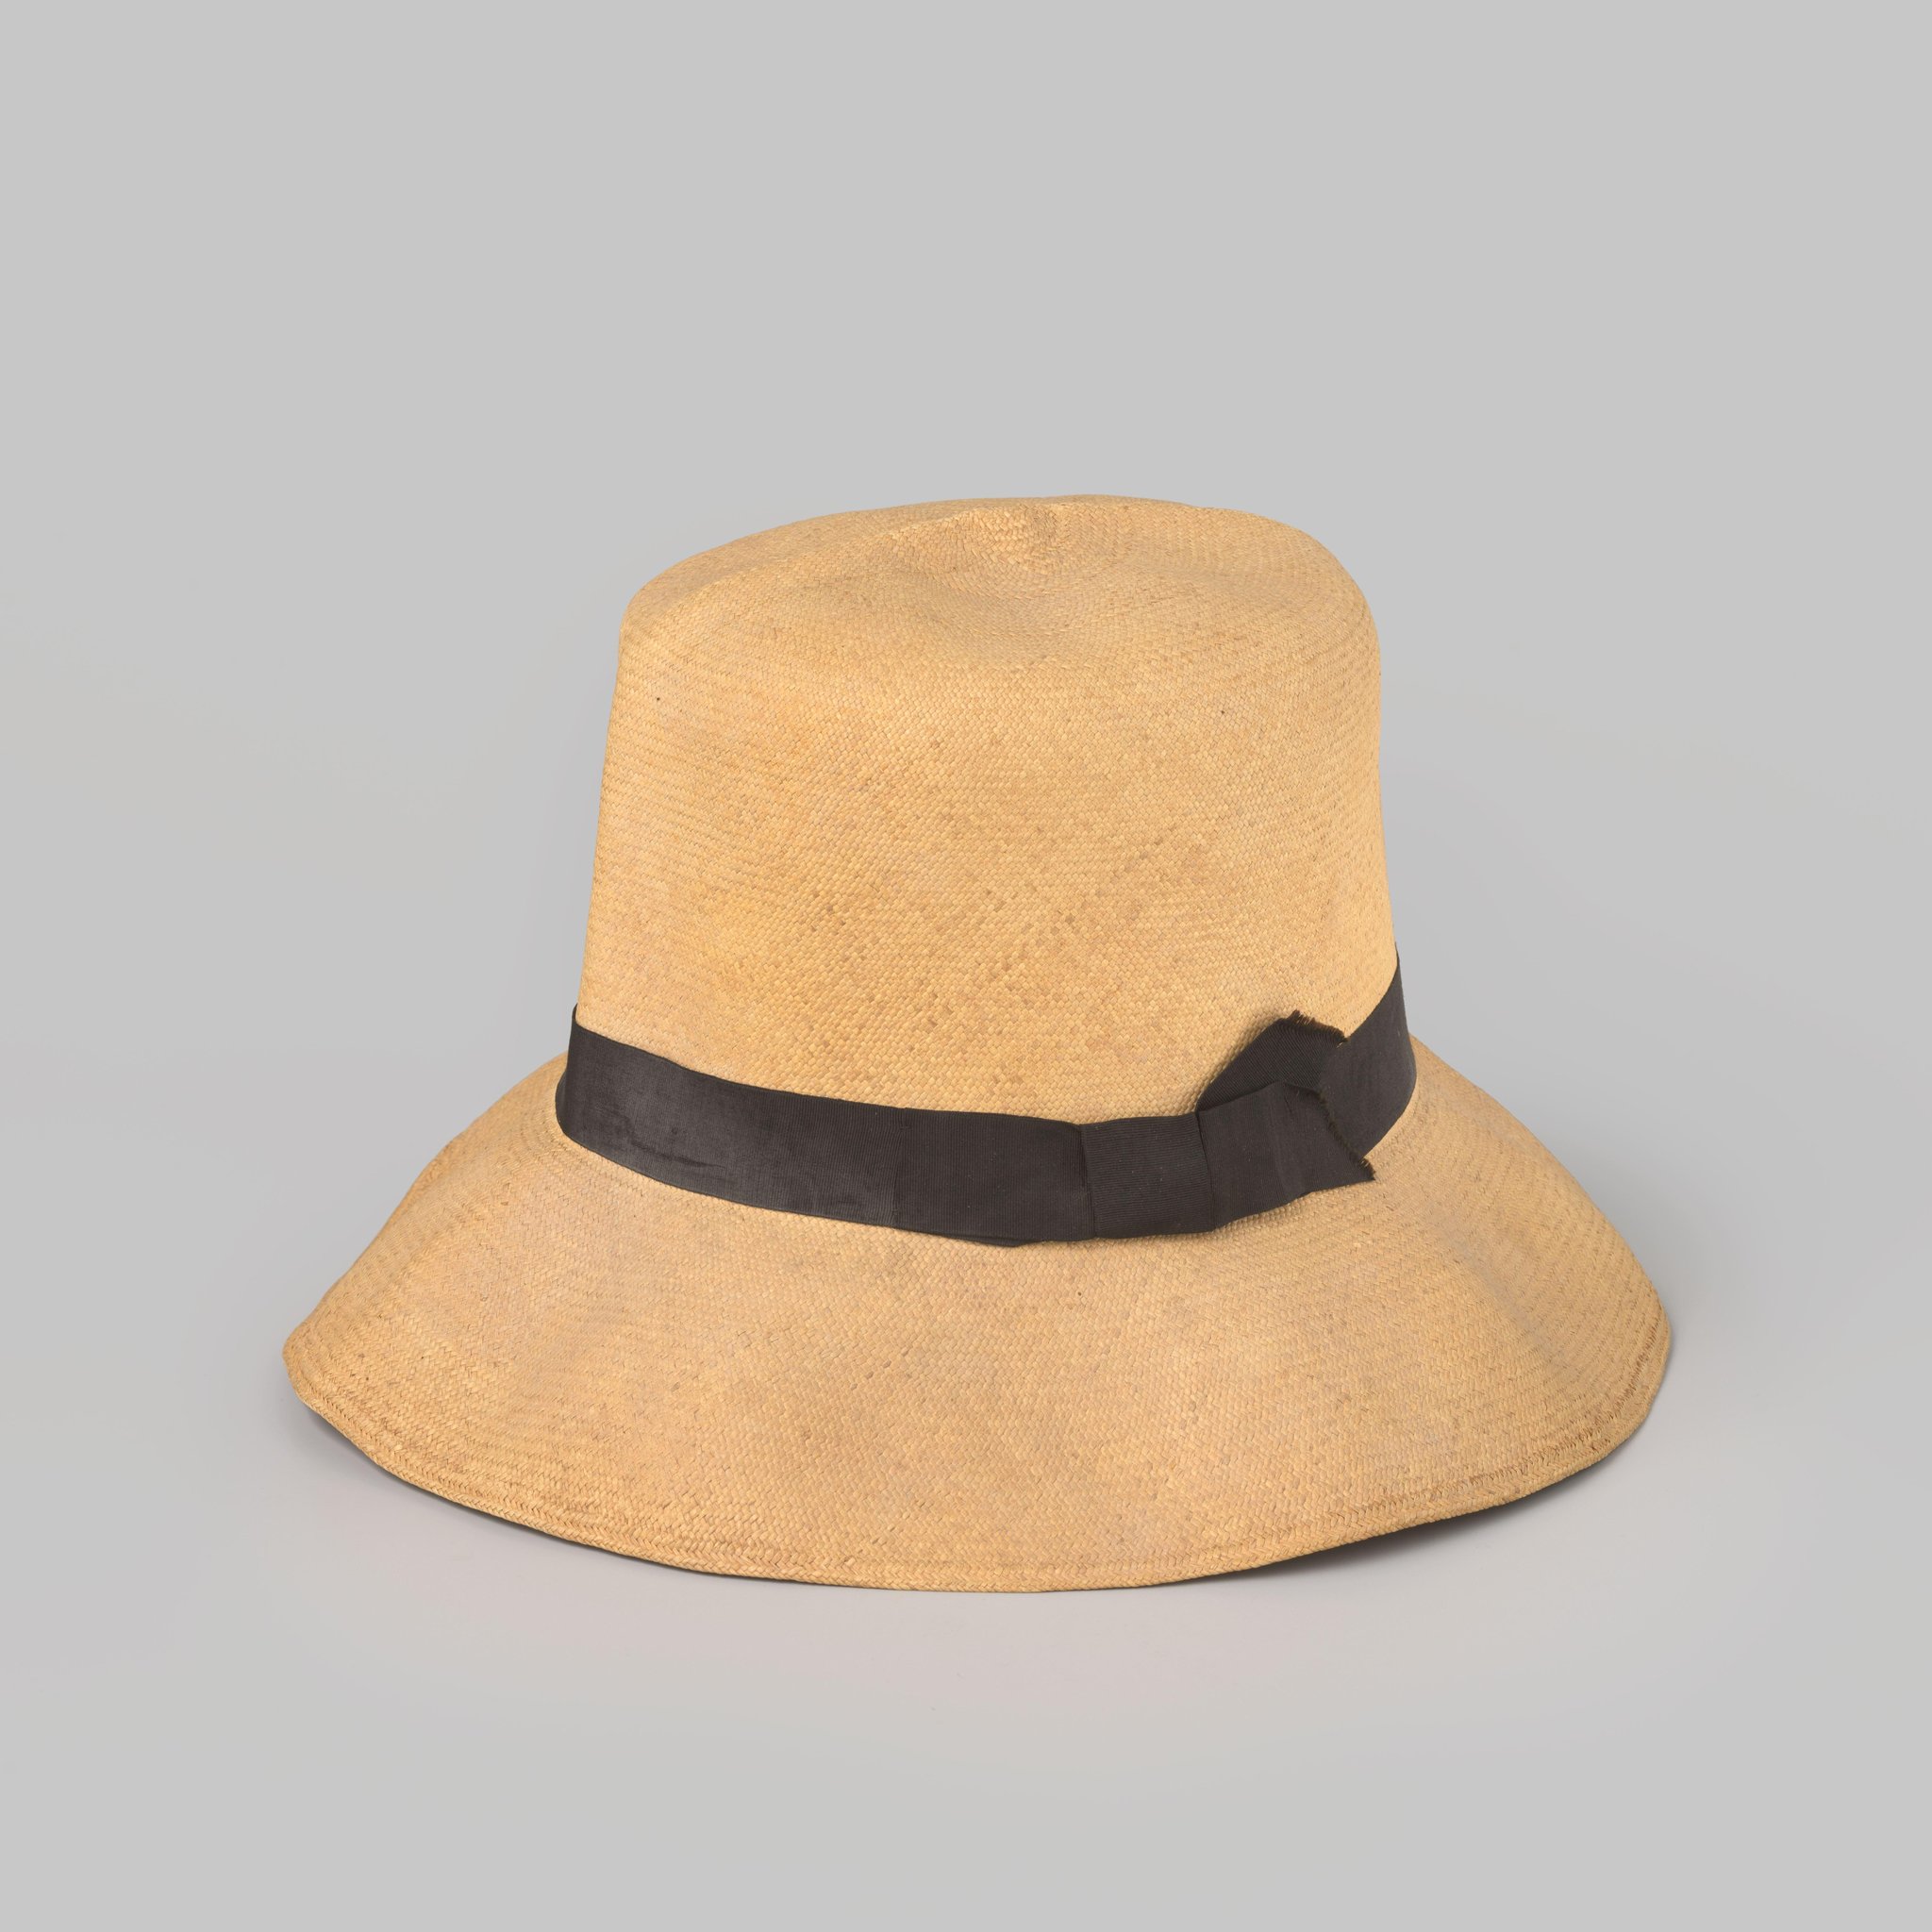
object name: hat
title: Tuinhoed van stro versierd met zwart ripslint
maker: Anonymous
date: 1920-1930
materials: leather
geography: london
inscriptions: mark: ‘A.J. White / 63 & 74, Jerrmynstreet / St. James's / S.W’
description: Tuinhoed van panama-stro. Geweven (?) stro, uit één stuk. Model met hoge bol en neerhangende rand, versierd met zwart ripslint. Leren binnenband met adres: